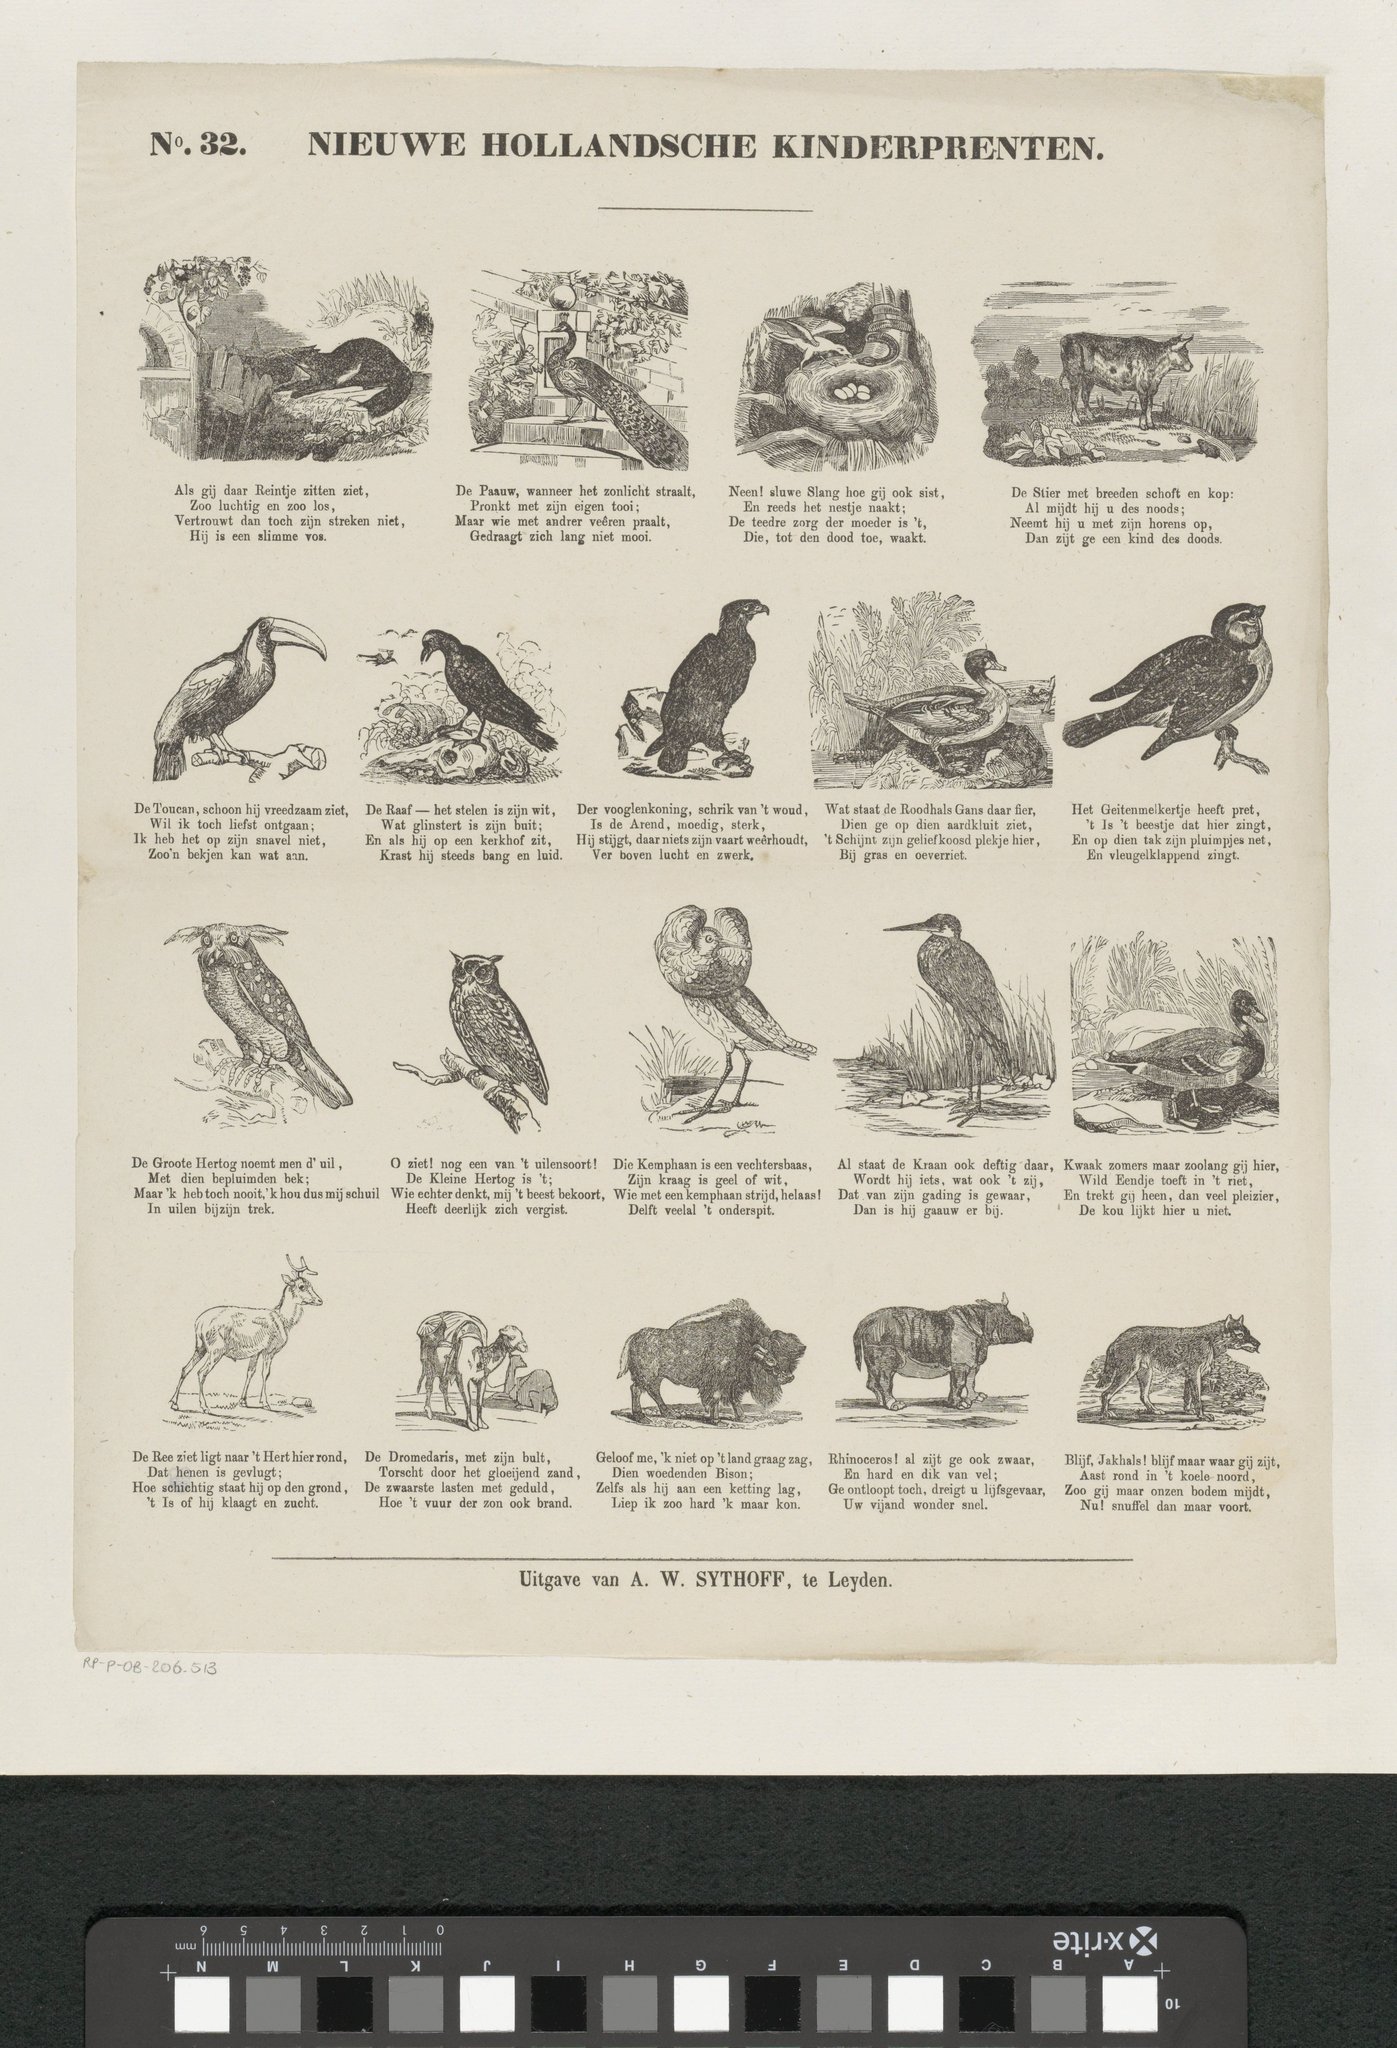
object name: print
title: Nieuwe Hollandsche kinderprenten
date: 1861-1929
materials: paper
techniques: letterpress printing, engraving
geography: europe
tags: bull, hoofed animals: dromedary, animals, birds, hoofed animals: rhinoceros, beasts of prey, predatory animals: fox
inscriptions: collector's mark: Lugt 2760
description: Blad met 19 voorstellingen van verschillende dieren, zoals een vos, een stier, vogels en een dromedaris. Onder elke voorstelling een vierregelig vers. Genummerd linksboven: No. 32.